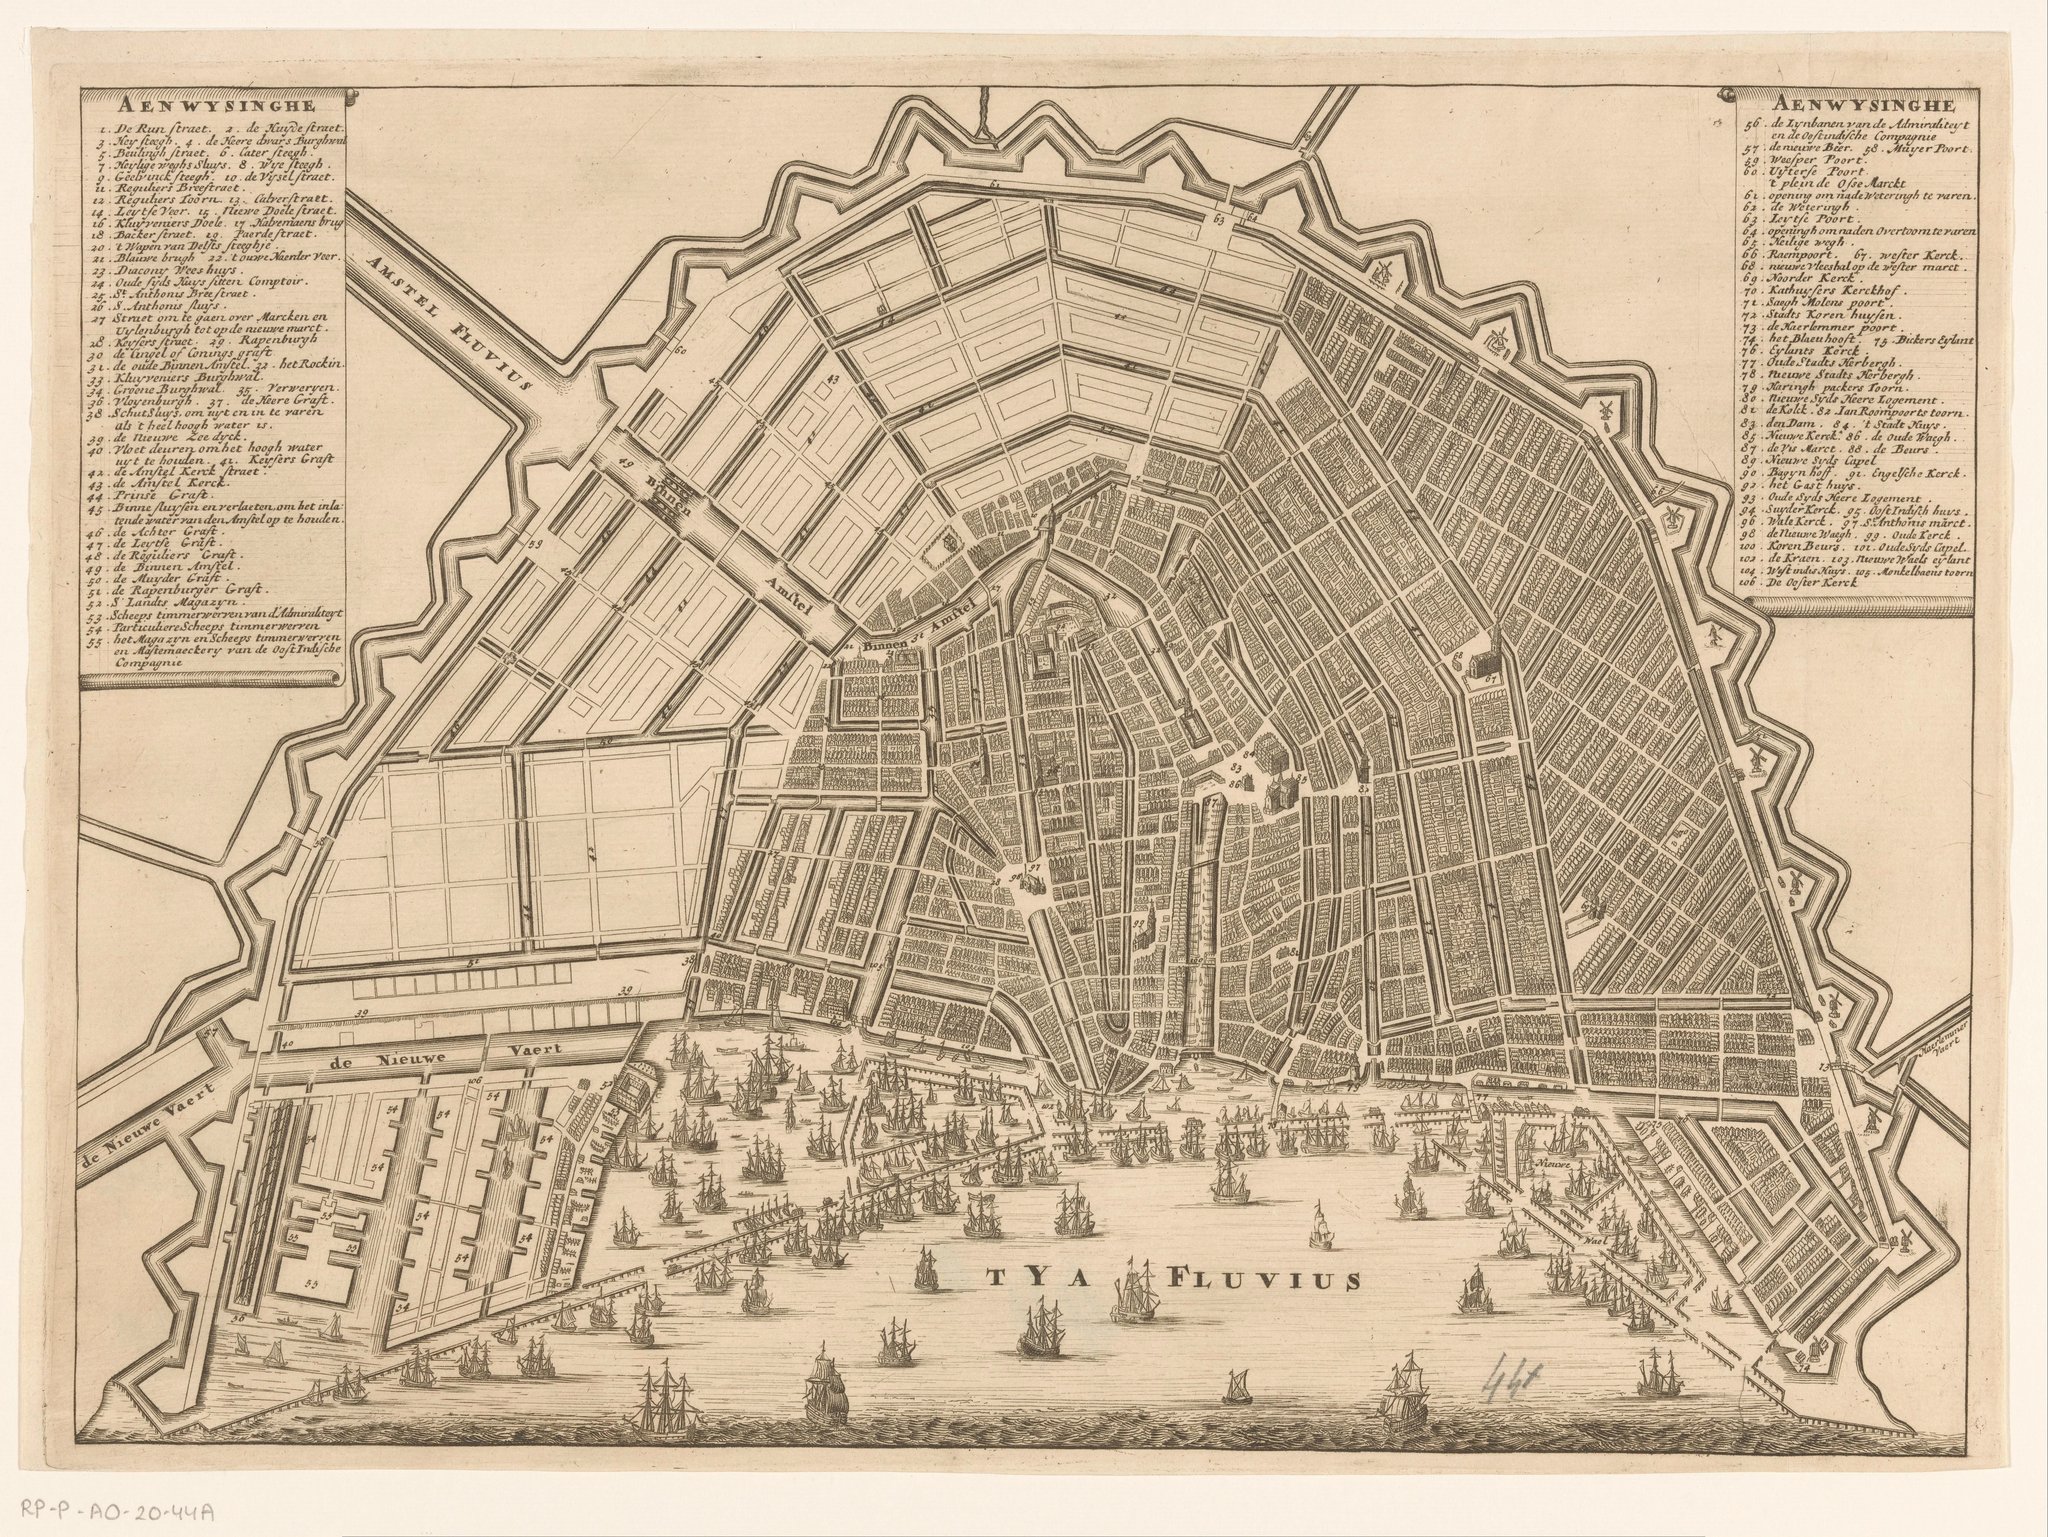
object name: print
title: Plattegrond van Amsterdam met ontwerp voor de Vierde Uitleg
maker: Anonymous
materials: paper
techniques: engraving, etching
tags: maps of cities, amsterdam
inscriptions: collector's mark: Lugt 2228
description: Plattegrond van Amsterdam met ontwerp voor de Vierde Uitleg, in vogelvluchtperspectief. Linksboven de legenda 1-55. Rechtsboven de legenda 56-106. Oriëntatie: zuidzuidwest boven.